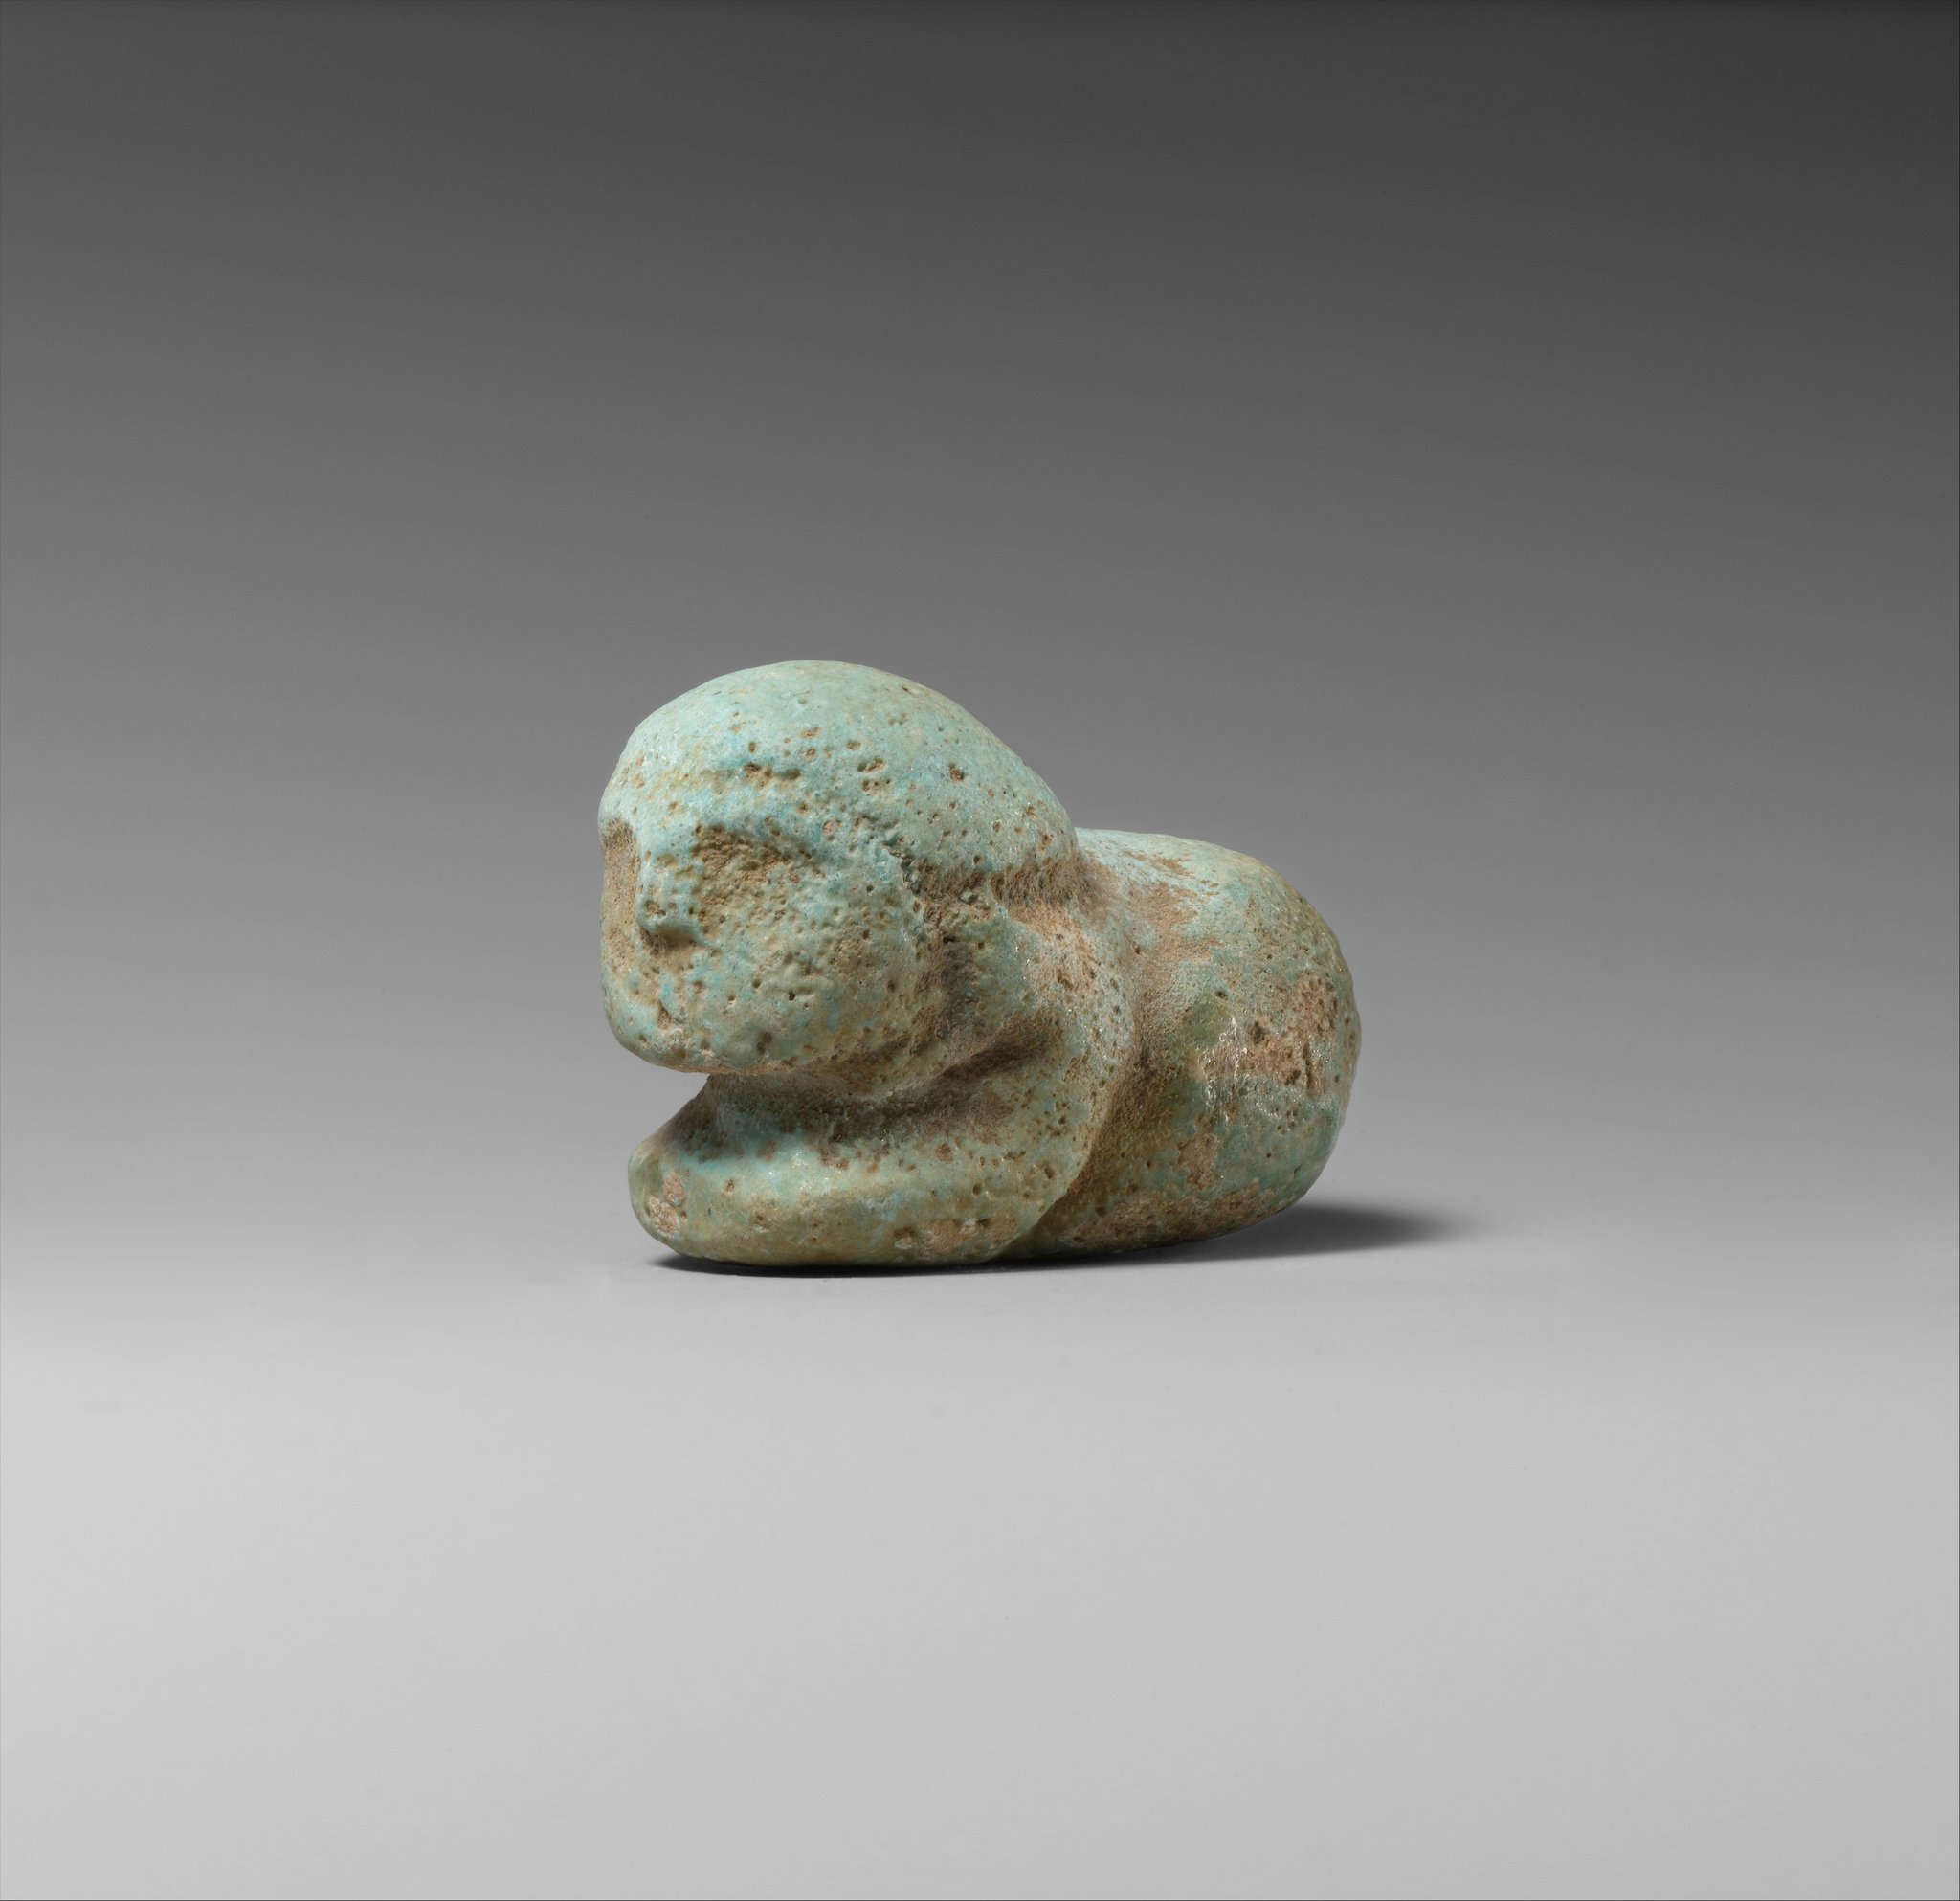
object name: figurine, obeisance, humble man crouch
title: Figure of a Crouched Man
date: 3100-2650 BCE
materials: faience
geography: egypt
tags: animals